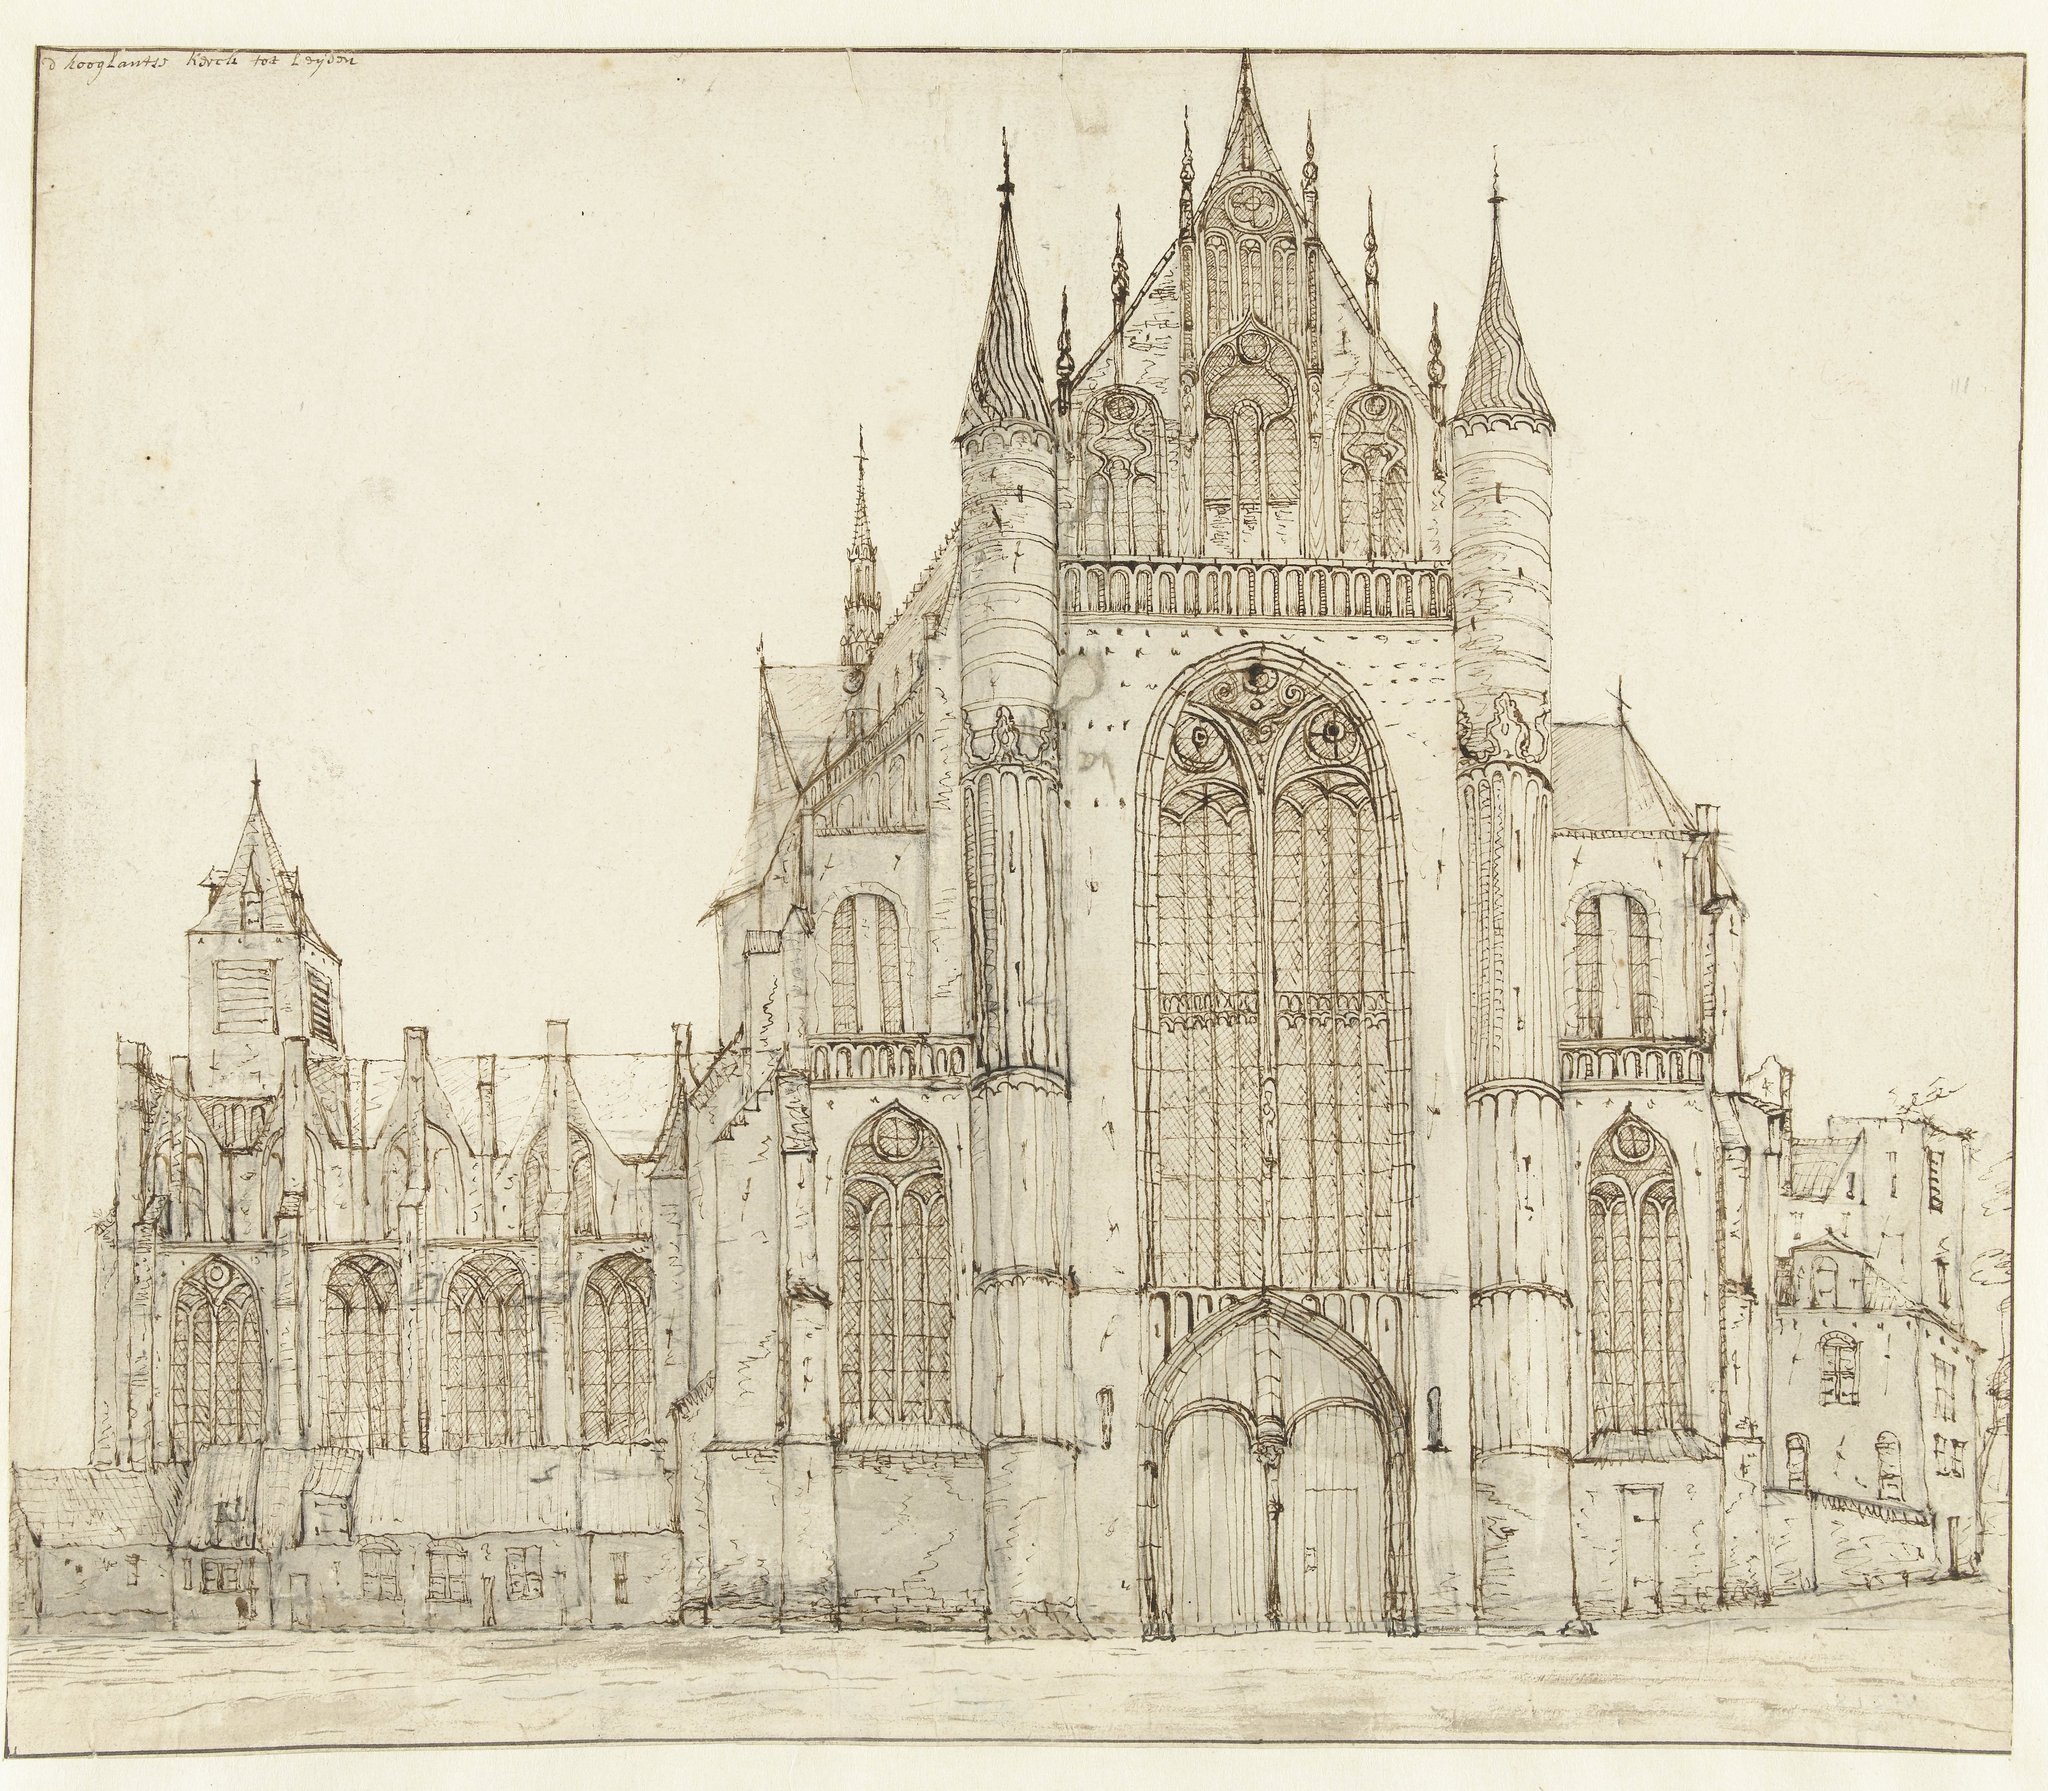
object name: drawing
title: Hooglandse kerk te Leiden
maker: gerrit berckheyde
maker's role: draughtsman, painter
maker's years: 1638-1698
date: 1648-1698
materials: chalk, graphite, ink, paper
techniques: brush, pen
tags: church (exterior)